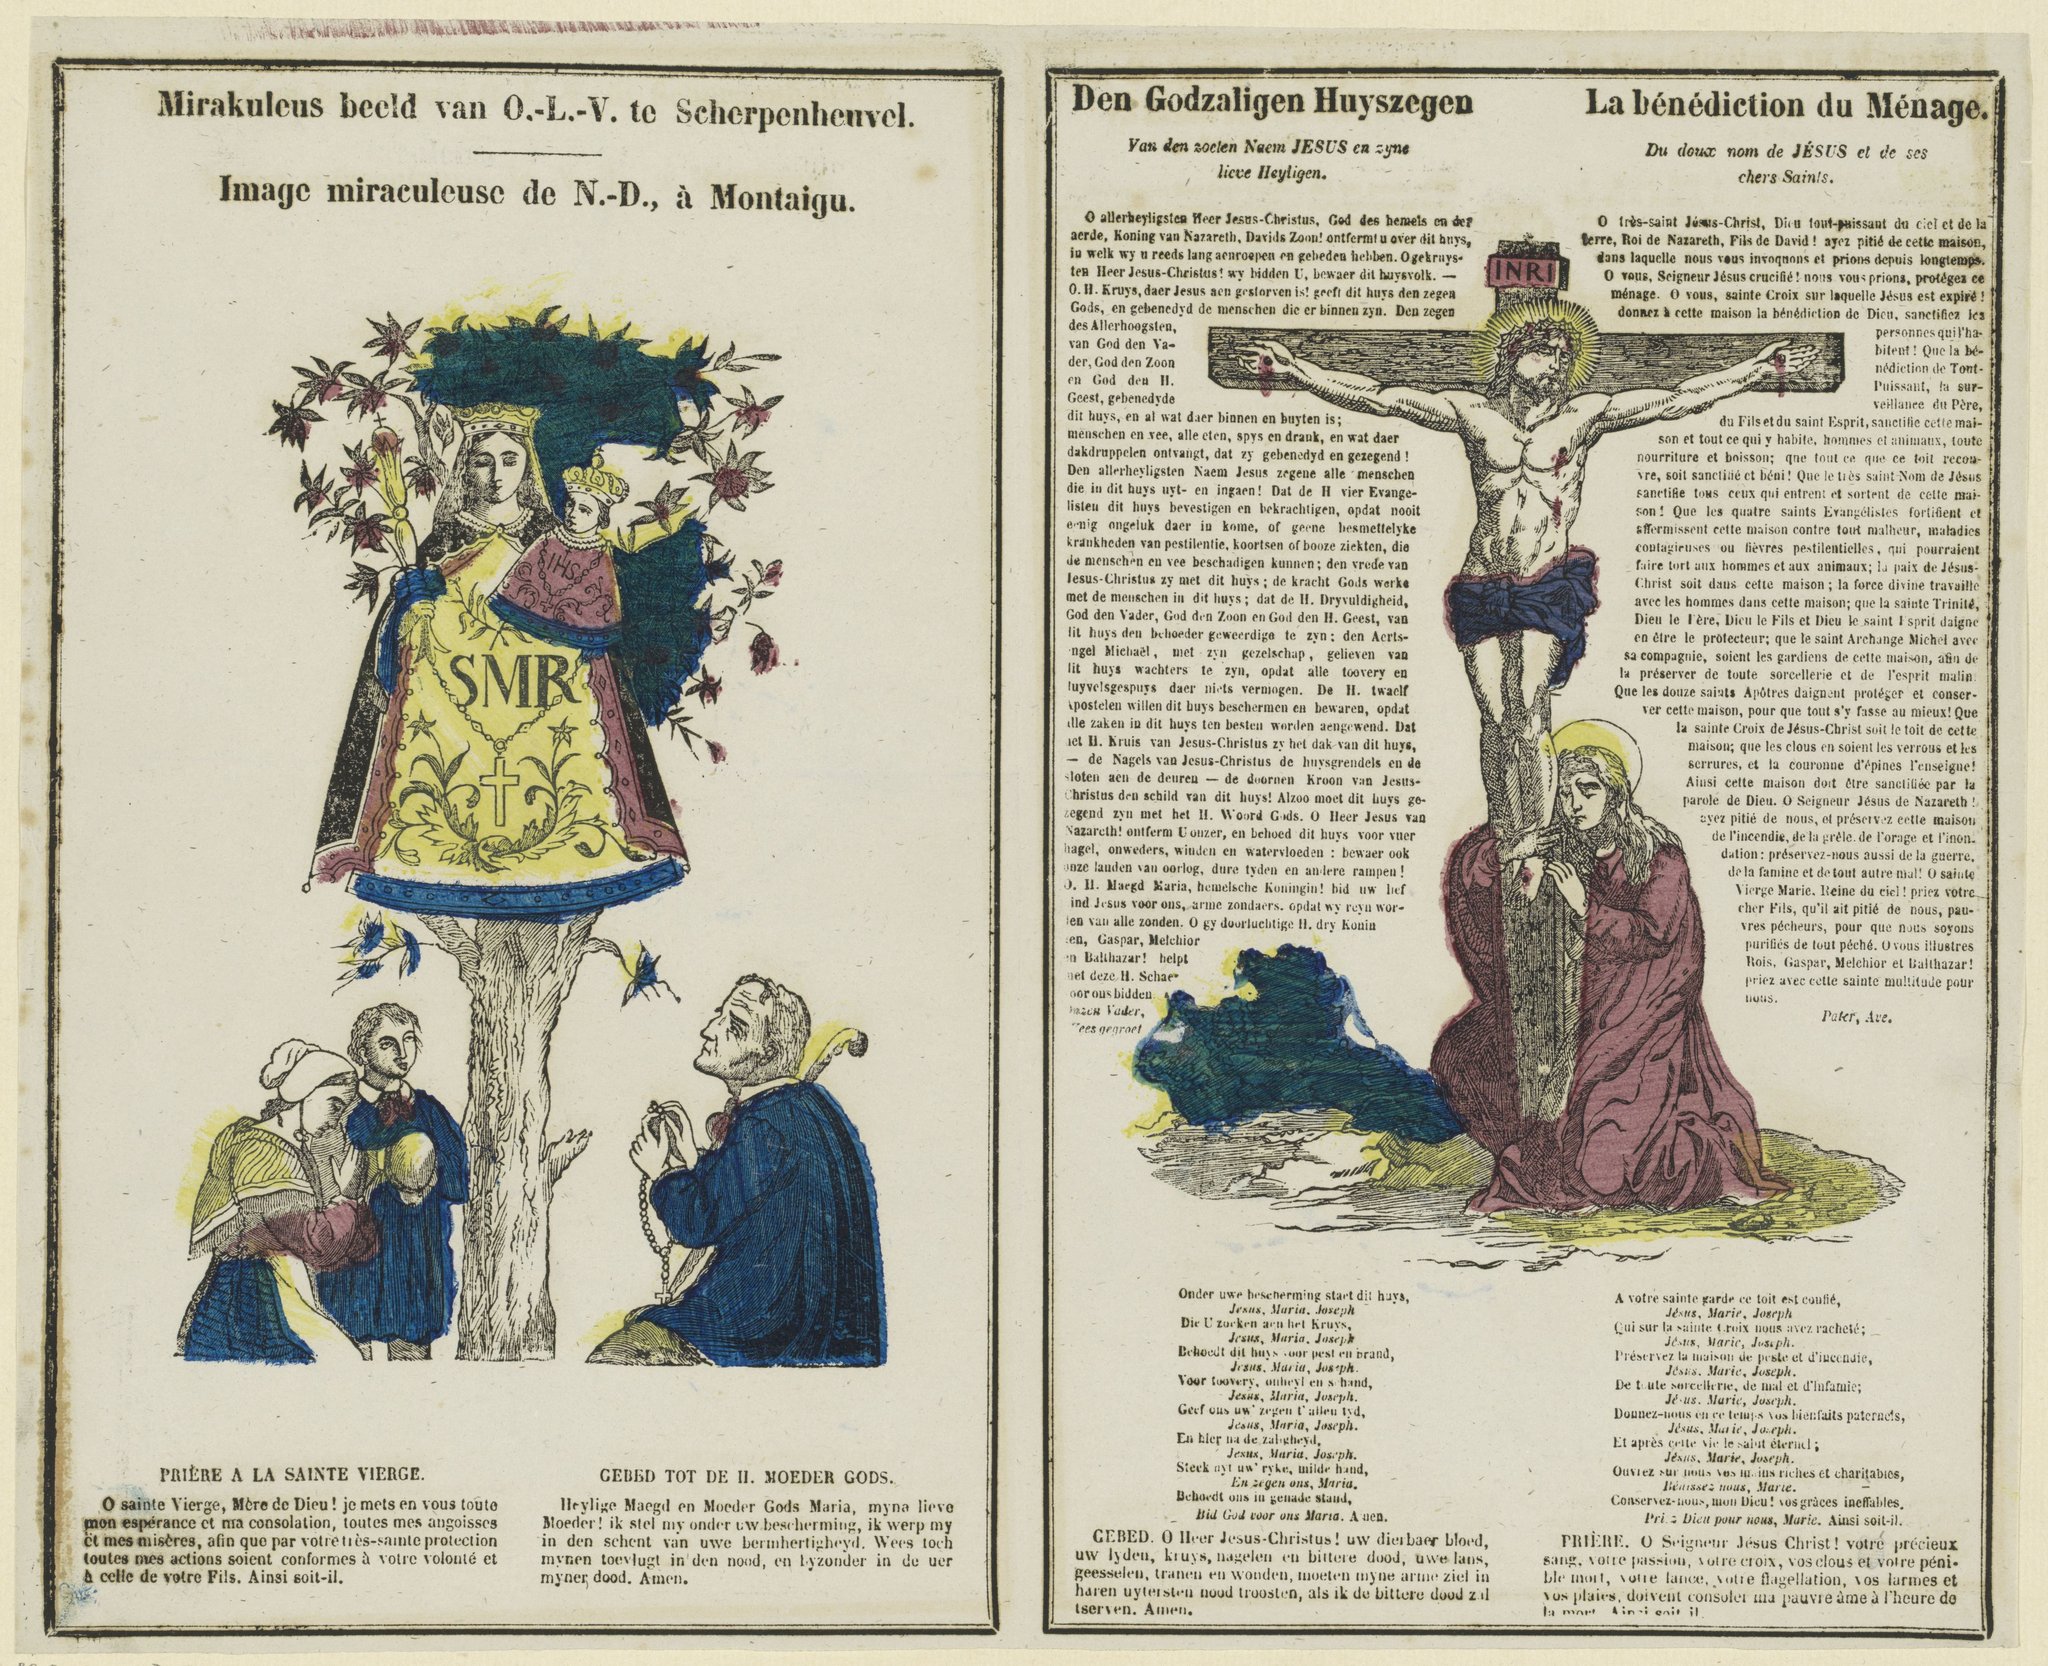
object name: print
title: Mirakuleus beeld van O.-L.-V. te Scherpenheuvel / Image miraculeuse de N.-D., à Montaigu / Den Godzaligen Huyszegen / La bénédiction du Ménage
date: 1827-1894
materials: paper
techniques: colour, letterpress printing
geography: schaarbeek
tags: madonna: i.e. mary with the christ-child, crucified christ with mary magdalene, who usually weeps and embraces the cross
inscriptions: collector's mark: Lugt 2760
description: Blad met 2 voorstellingen. Links een voorstelling van de Onze-Lieve-Vrouw van Scherpenheuvel in een boom met daaronder mensen in gebed. Rechts een voorstelling van Maria Magdalena treurend aan de voeten van de gekruisigde Christus. Beide voorstellingen worden omgeven door een kader. Bij beide voorstellingen een bijschrift in het Nederlands en in het Frans.